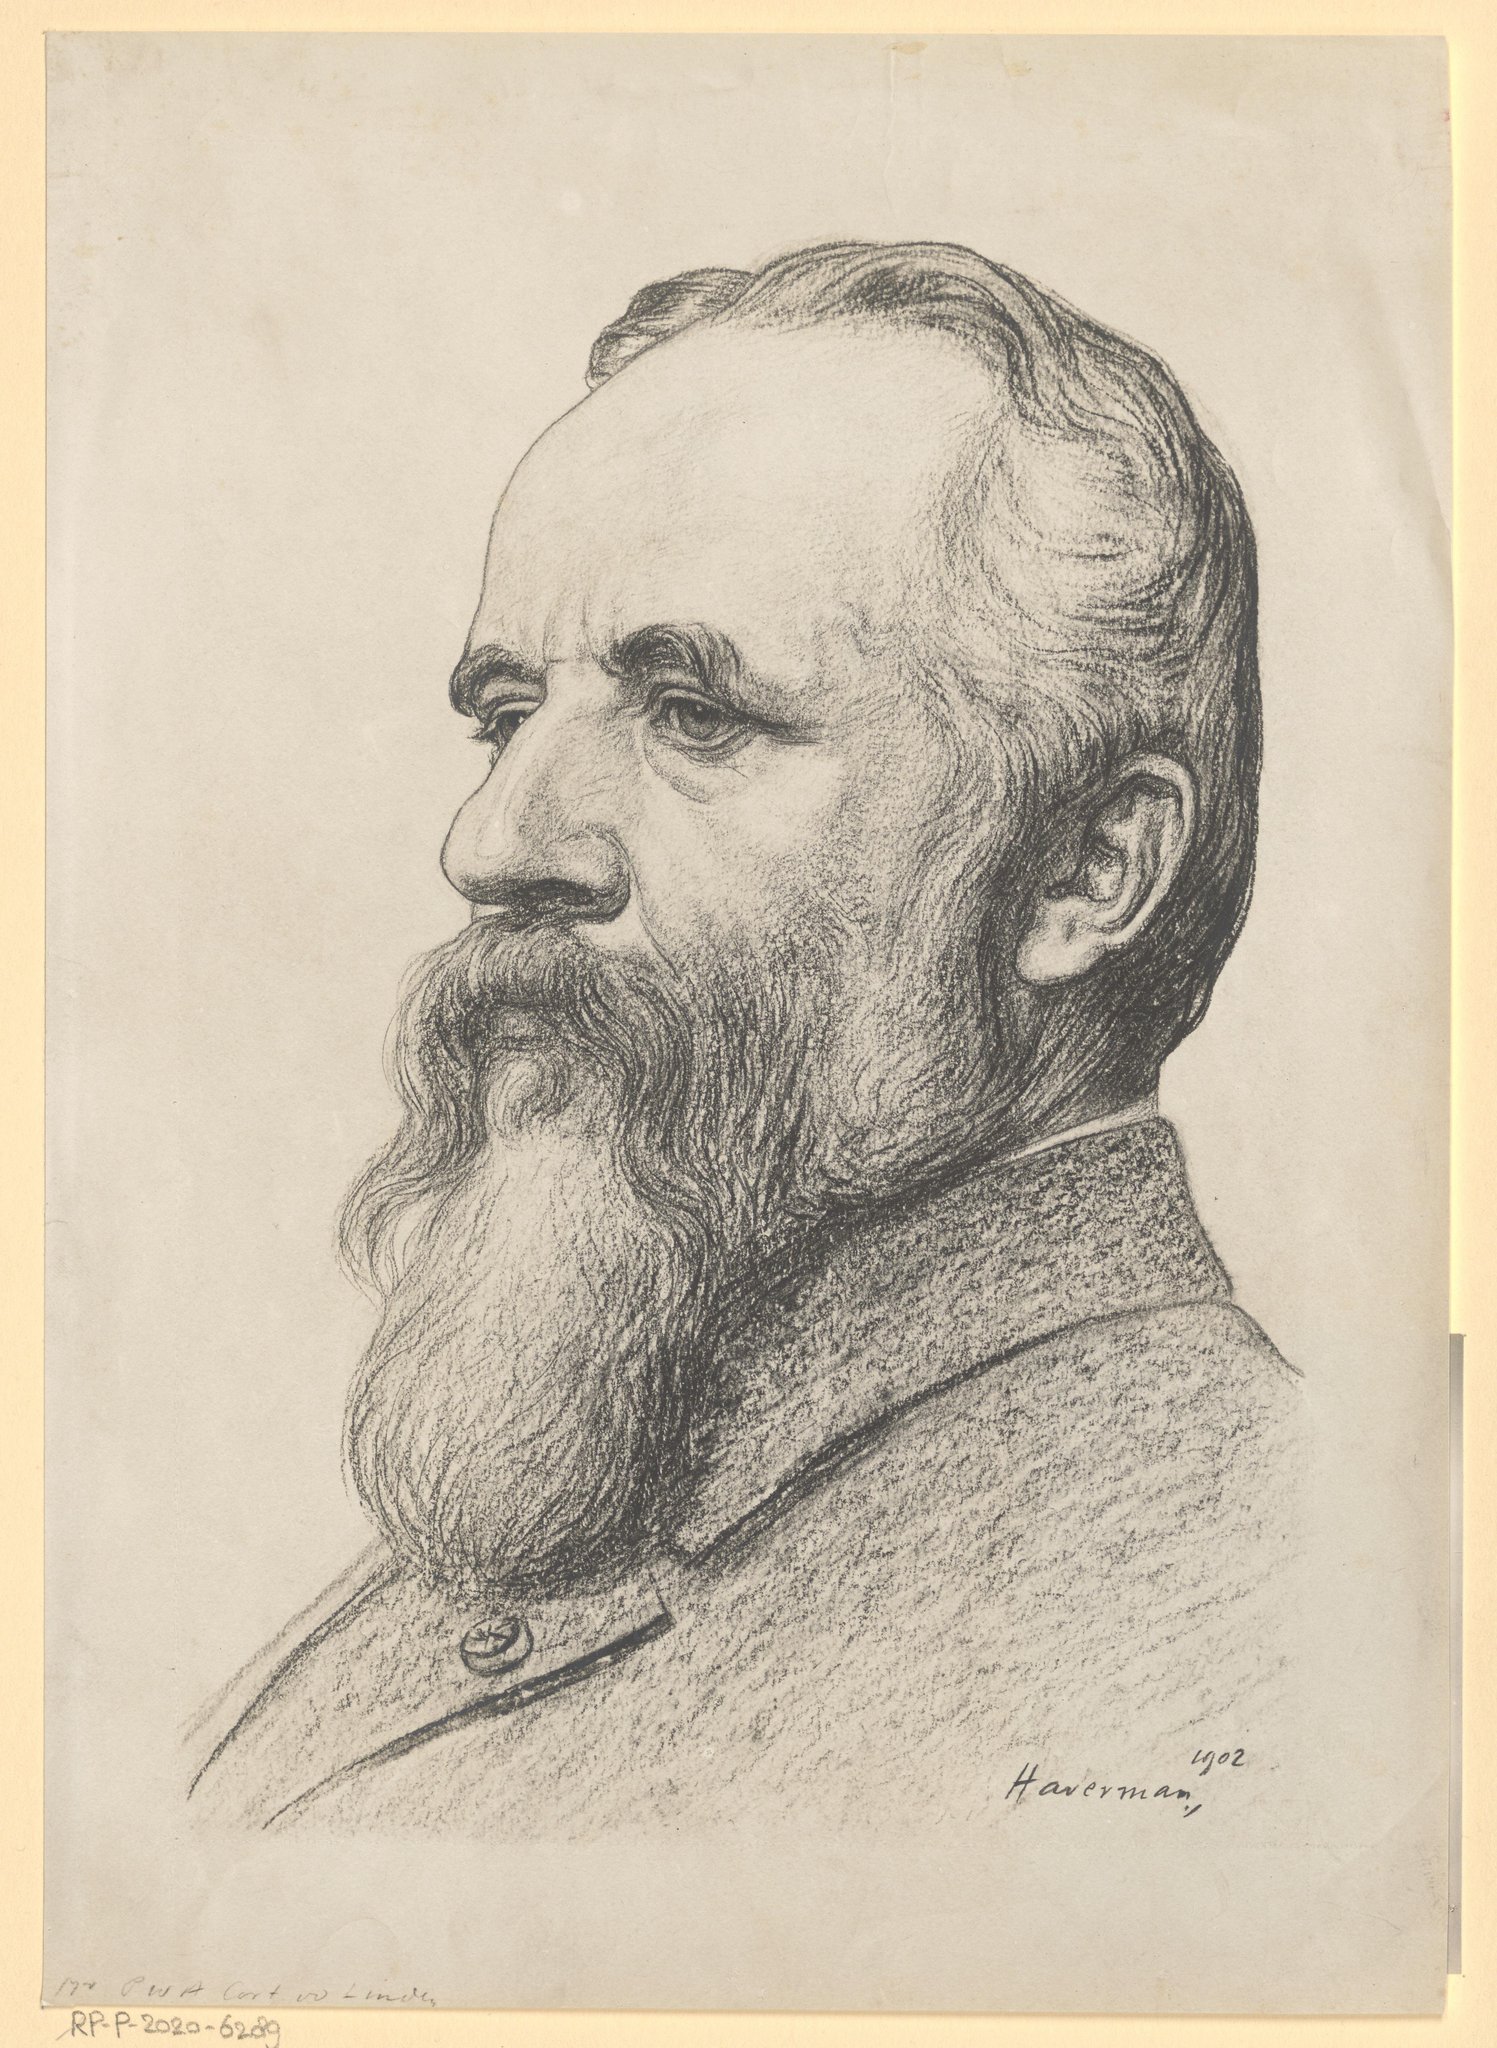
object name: print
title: Portret van Pieter Wilhelm Adriaan Cort van der Linden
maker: Anonymous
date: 1902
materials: paper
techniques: lithograph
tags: politician, historical persons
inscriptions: date